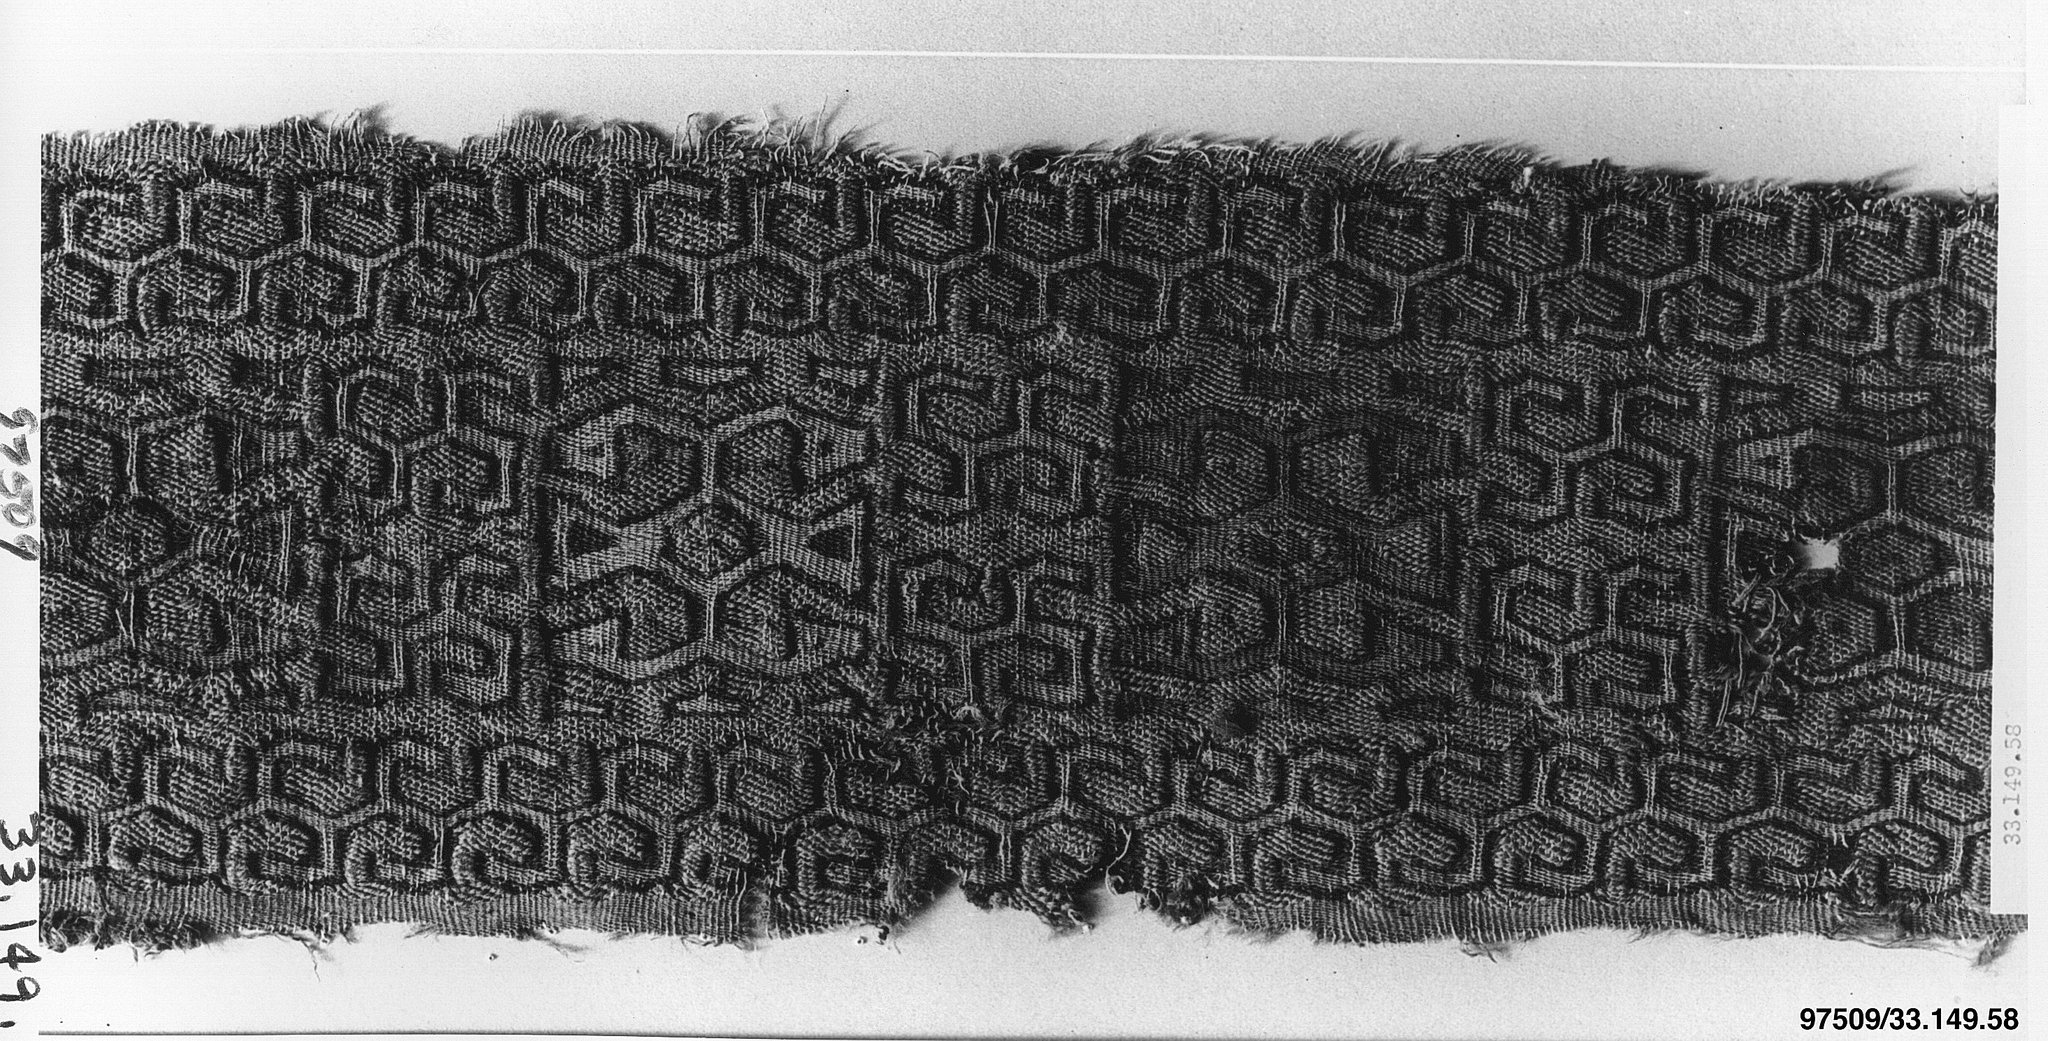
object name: textile fragment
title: Fragment with Hook Pattern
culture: ica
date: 901-1500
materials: animal fiber, cotton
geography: peru